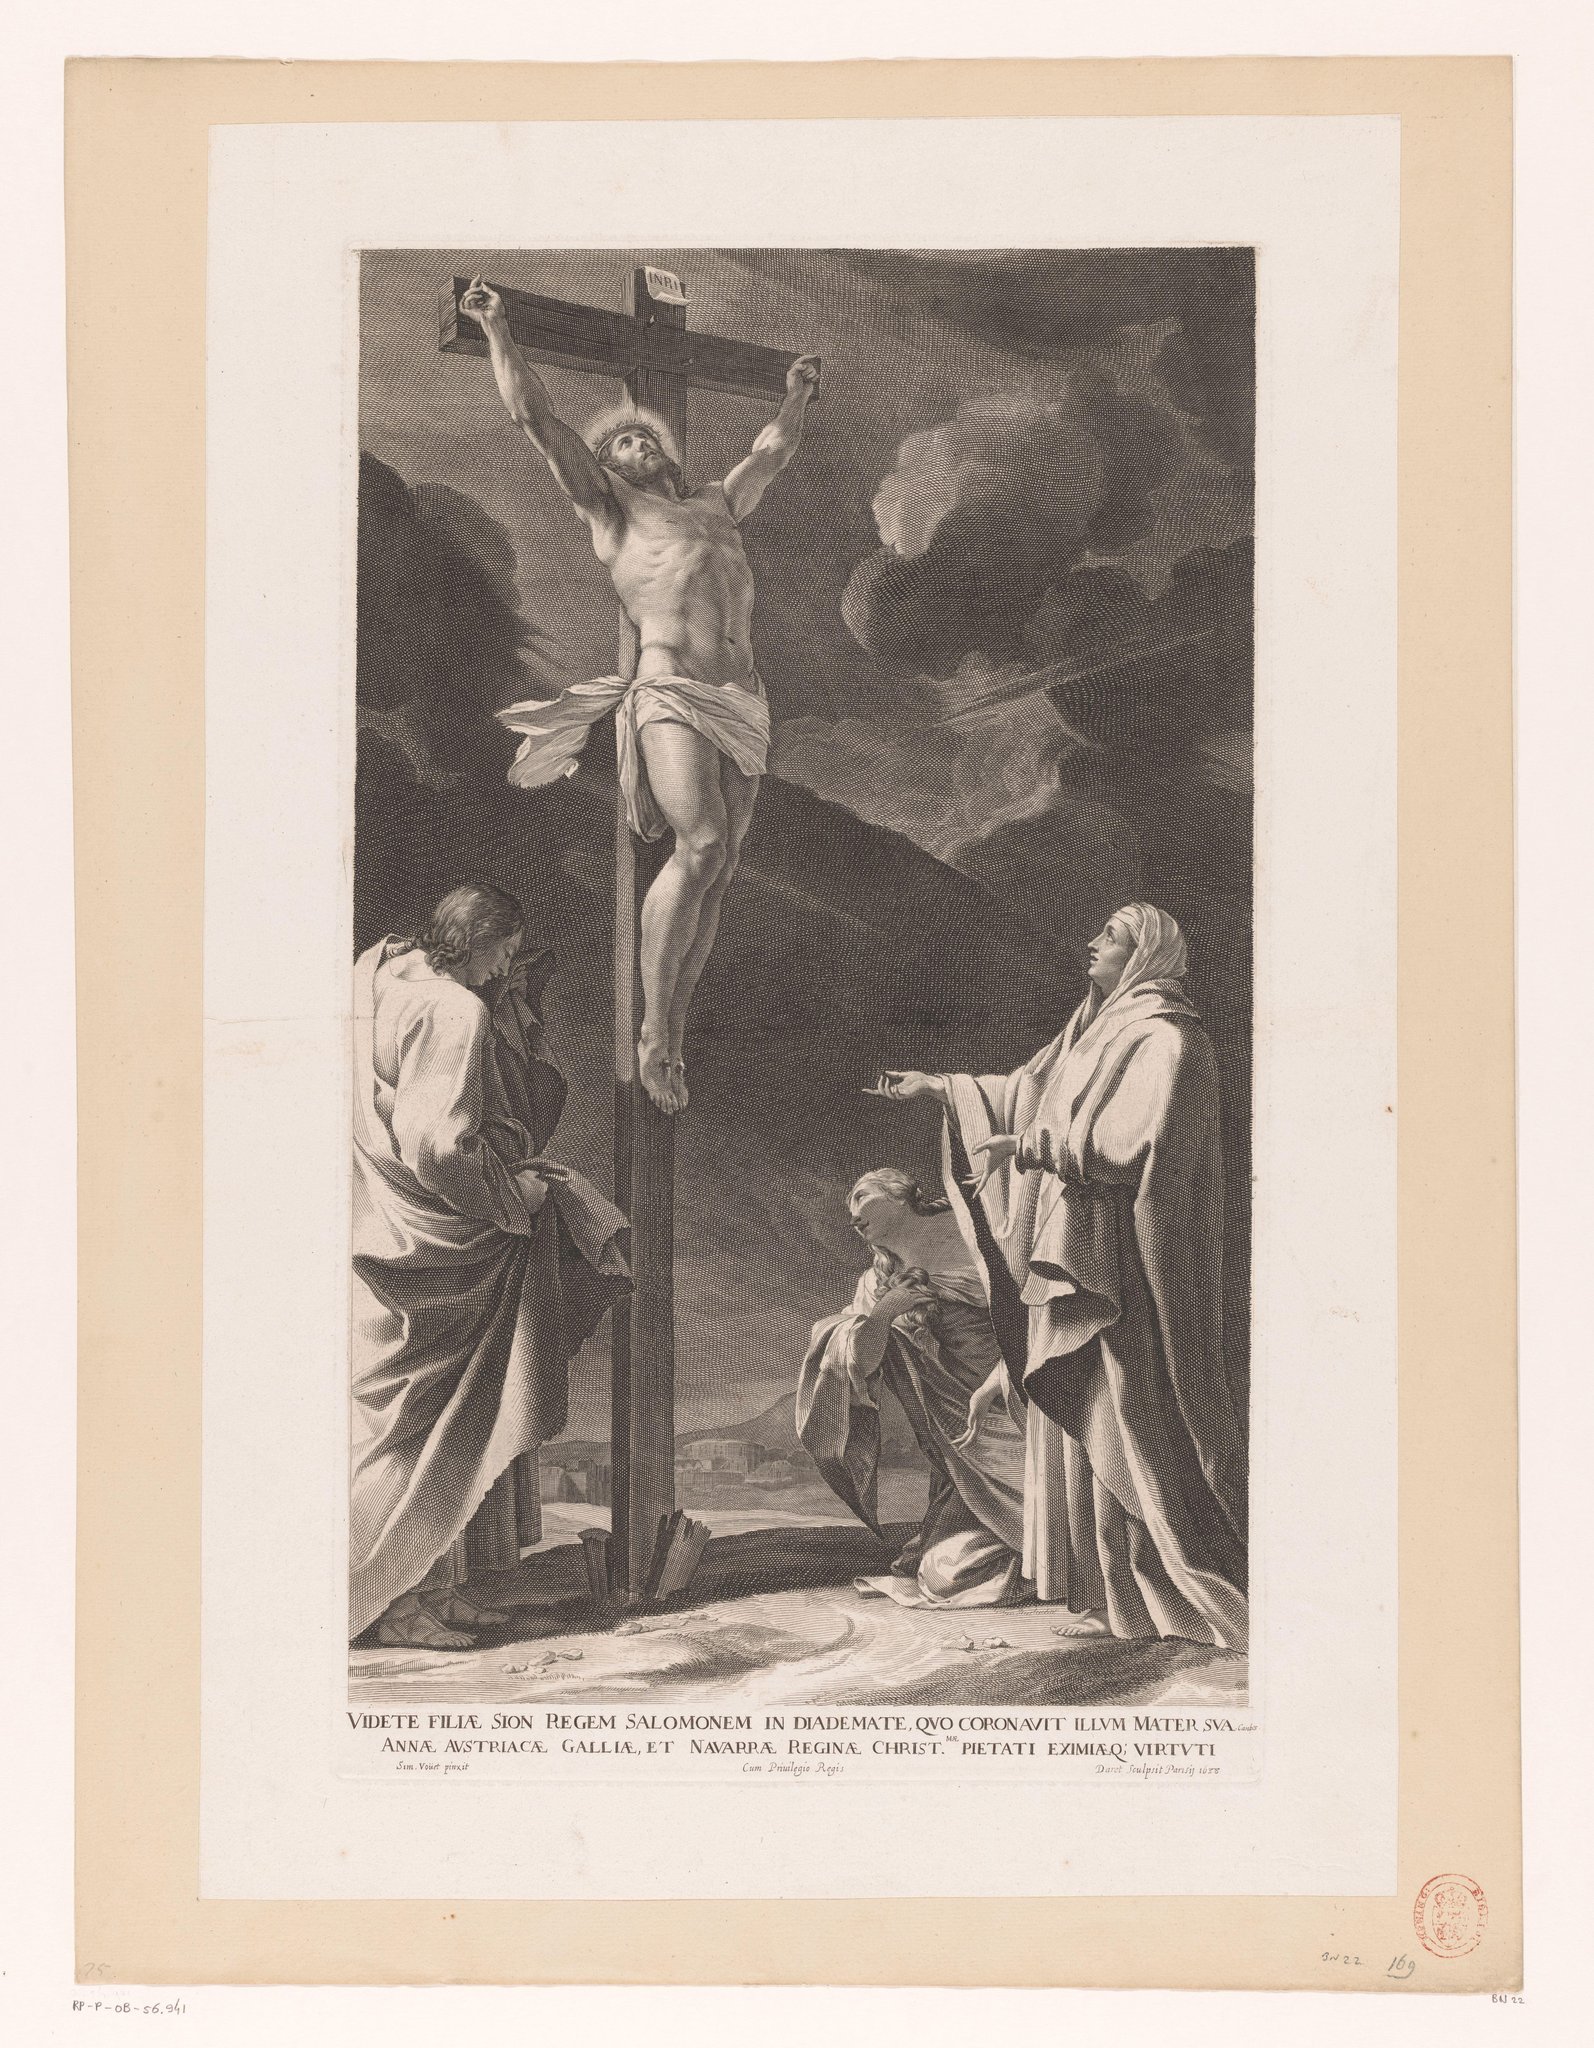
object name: print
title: Kruisiging met Johannes, Maria en Magdalena aan de voet van het kruis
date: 1638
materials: paper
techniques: engraving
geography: paris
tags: crucified christ with mary, john, and mary magdalene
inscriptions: collector's mark: Lugt 240